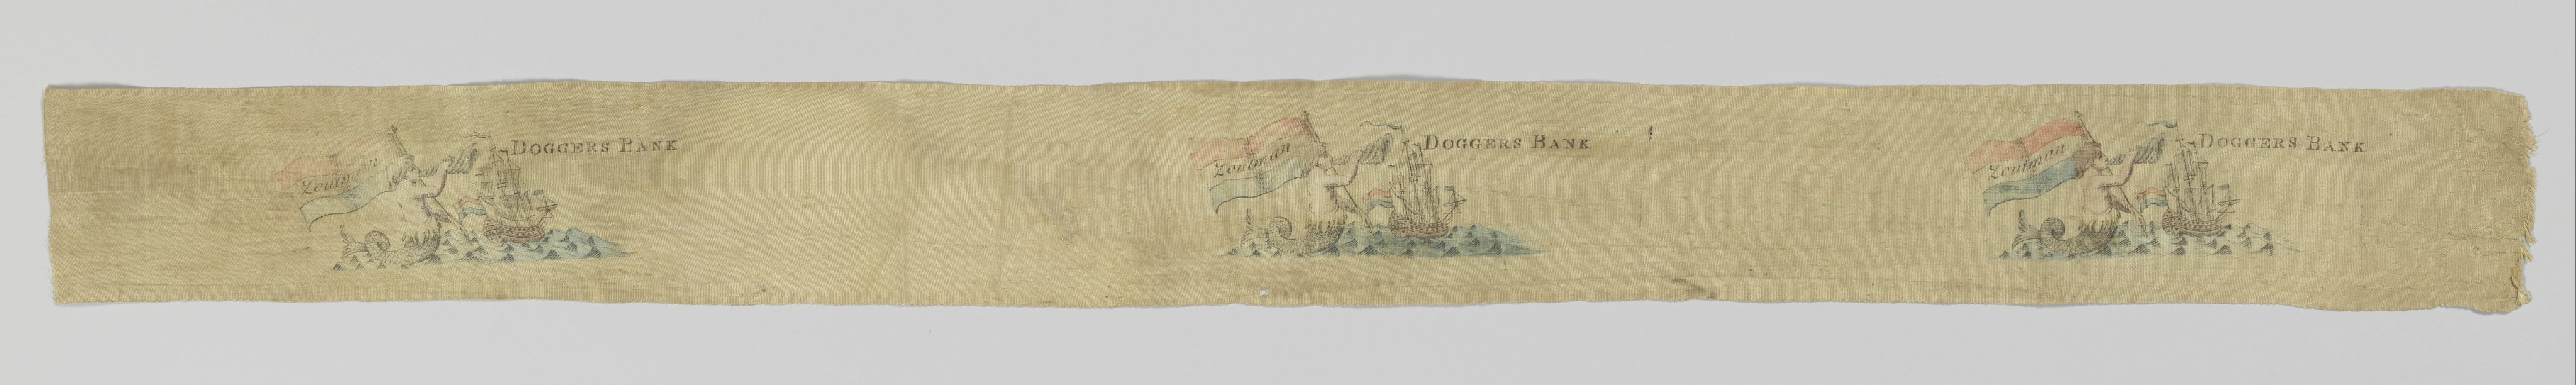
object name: ribbon material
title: Doggersbanklint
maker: Anonymous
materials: silk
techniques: printing, weave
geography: netherlands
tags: the hague, johan arnold zoutman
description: Lint met driemaal dezelfde voorstelling: een triton met een schelp in de vorm van een hoorn aan zijn mond en een rood-wit-blauwe vlag in zijn linkerhand, rechts van hem een schip met rood-wit-blauwe vlag op zee, daar rechtsboven het opschrift: DOGGERSBANK (3 x herhaald). Op vlag: Zoutman (3 x herhaald).